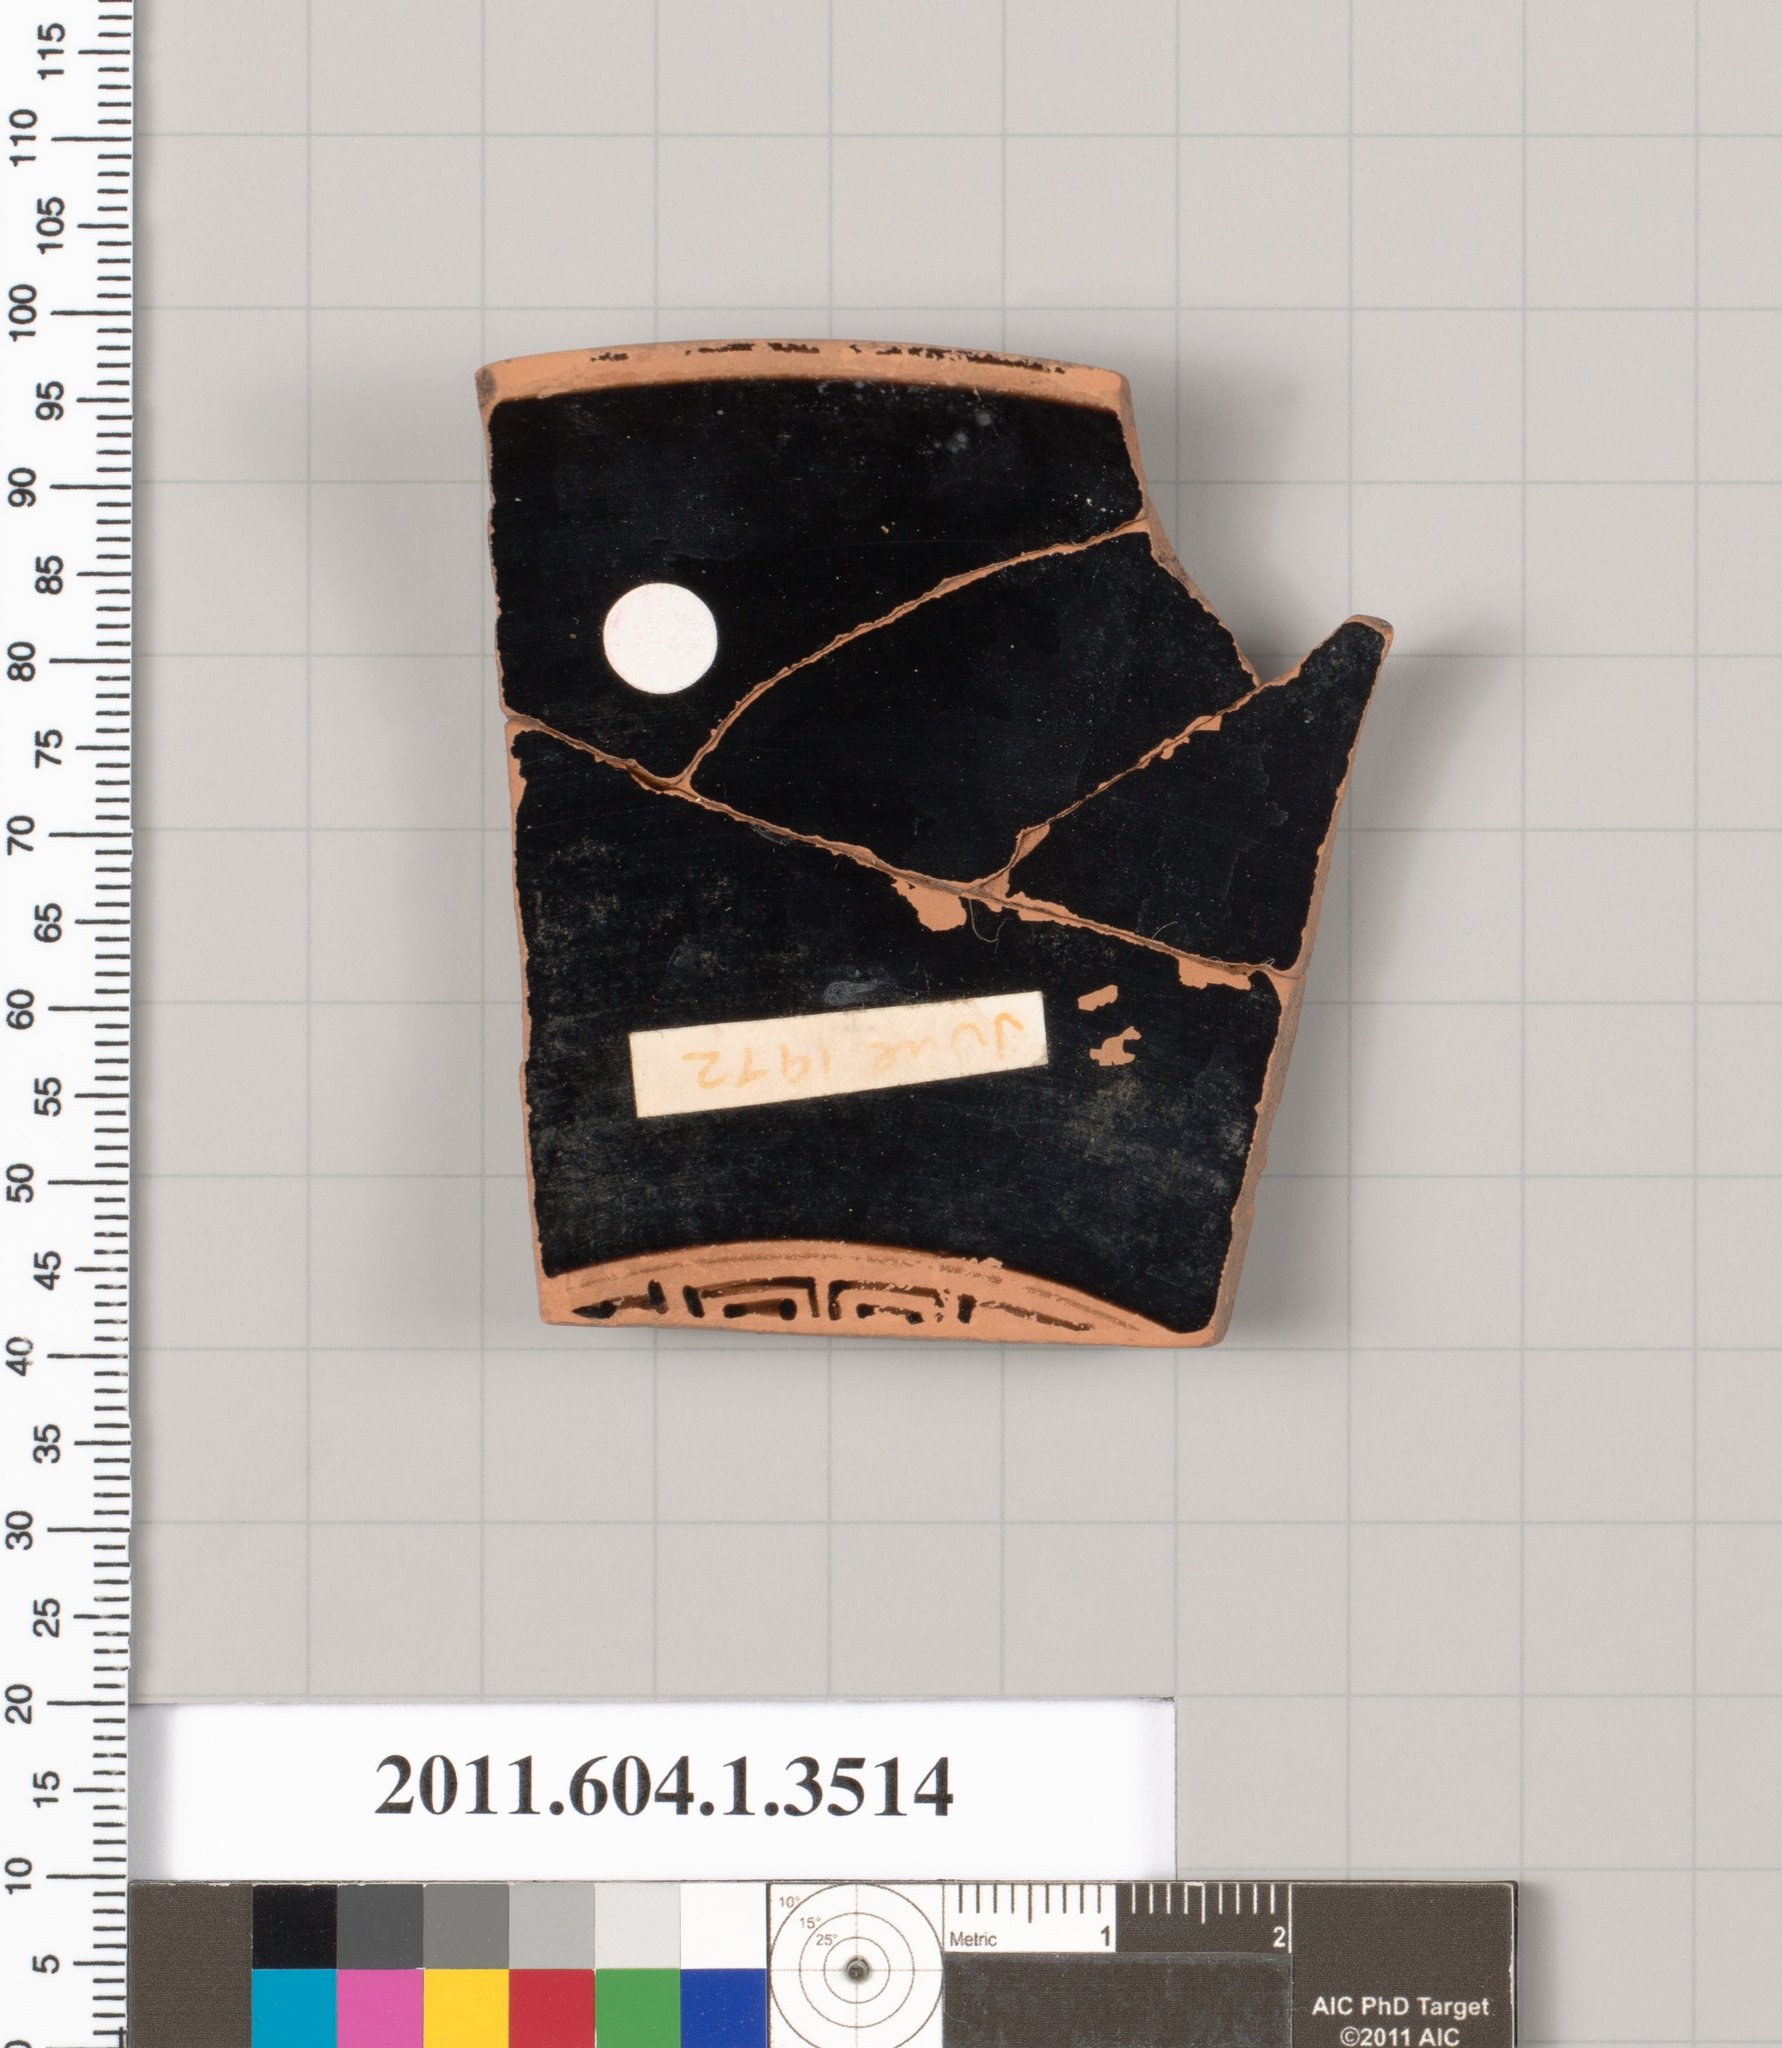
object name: kylix fragment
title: Terracotta fragment of a kylix (drinking cup)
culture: greek, attic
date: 467-435 BCE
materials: terracotta